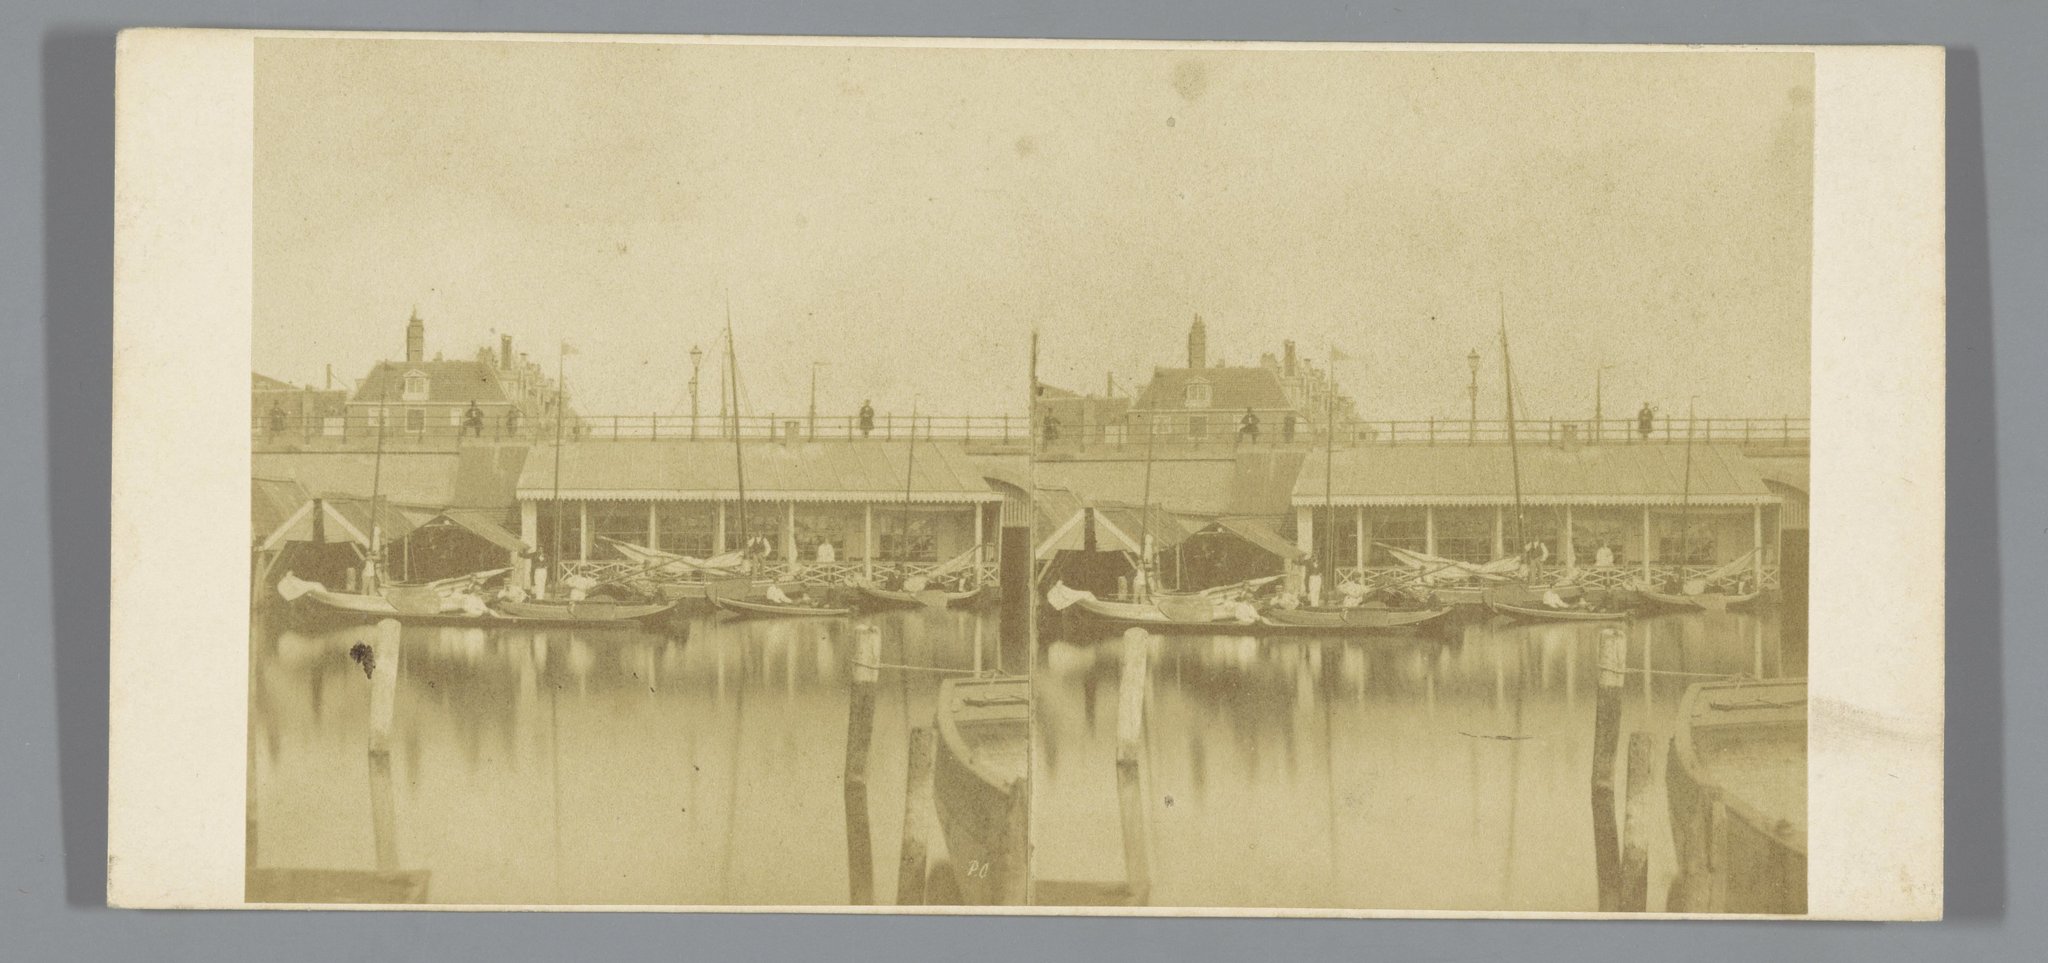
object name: stereograph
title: Vues de Hollande, Amsterdam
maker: pieter oosterhuis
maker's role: draughtsman, print maker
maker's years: 1816-1885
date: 1859-1870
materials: cardboard, paper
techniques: albumen print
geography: amsterdam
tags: harbour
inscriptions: initials: ‘P.O.’, inscription: ‘gesigneerd P(ieter) O(osterhuis)’, number: ‘261.’